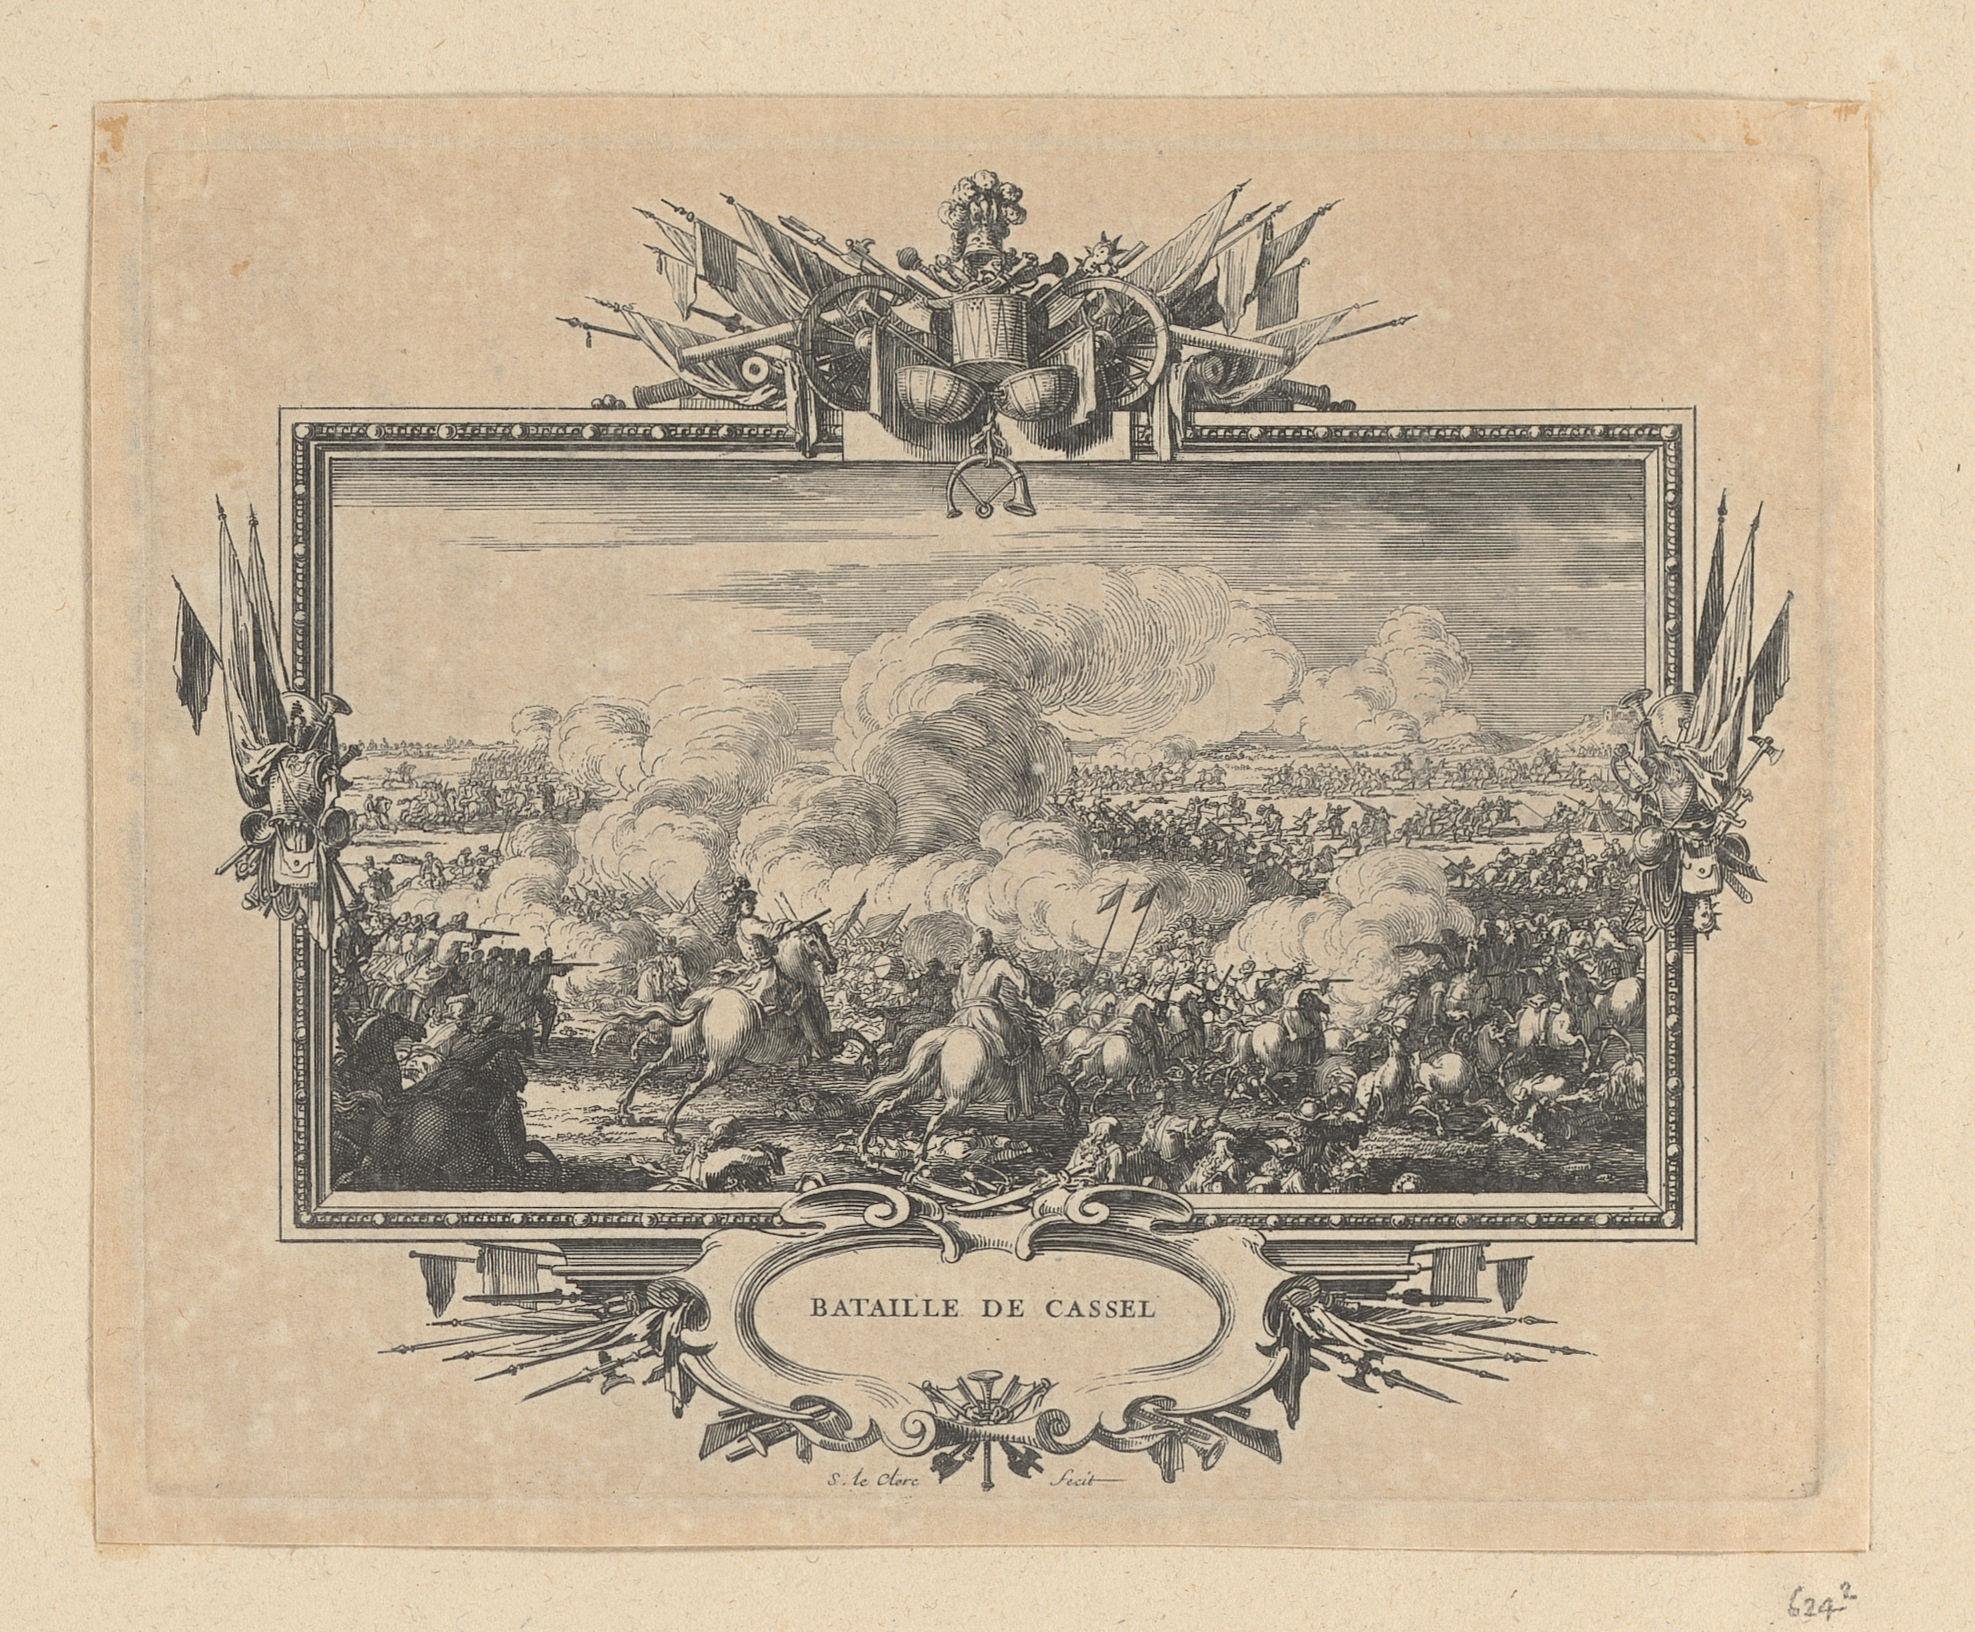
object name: print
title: Slag bij Kassel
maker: sébastien leclerc (i)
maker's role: print maker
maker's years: 1637-1714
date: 1702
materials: paper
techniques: engraving, etching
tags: battle